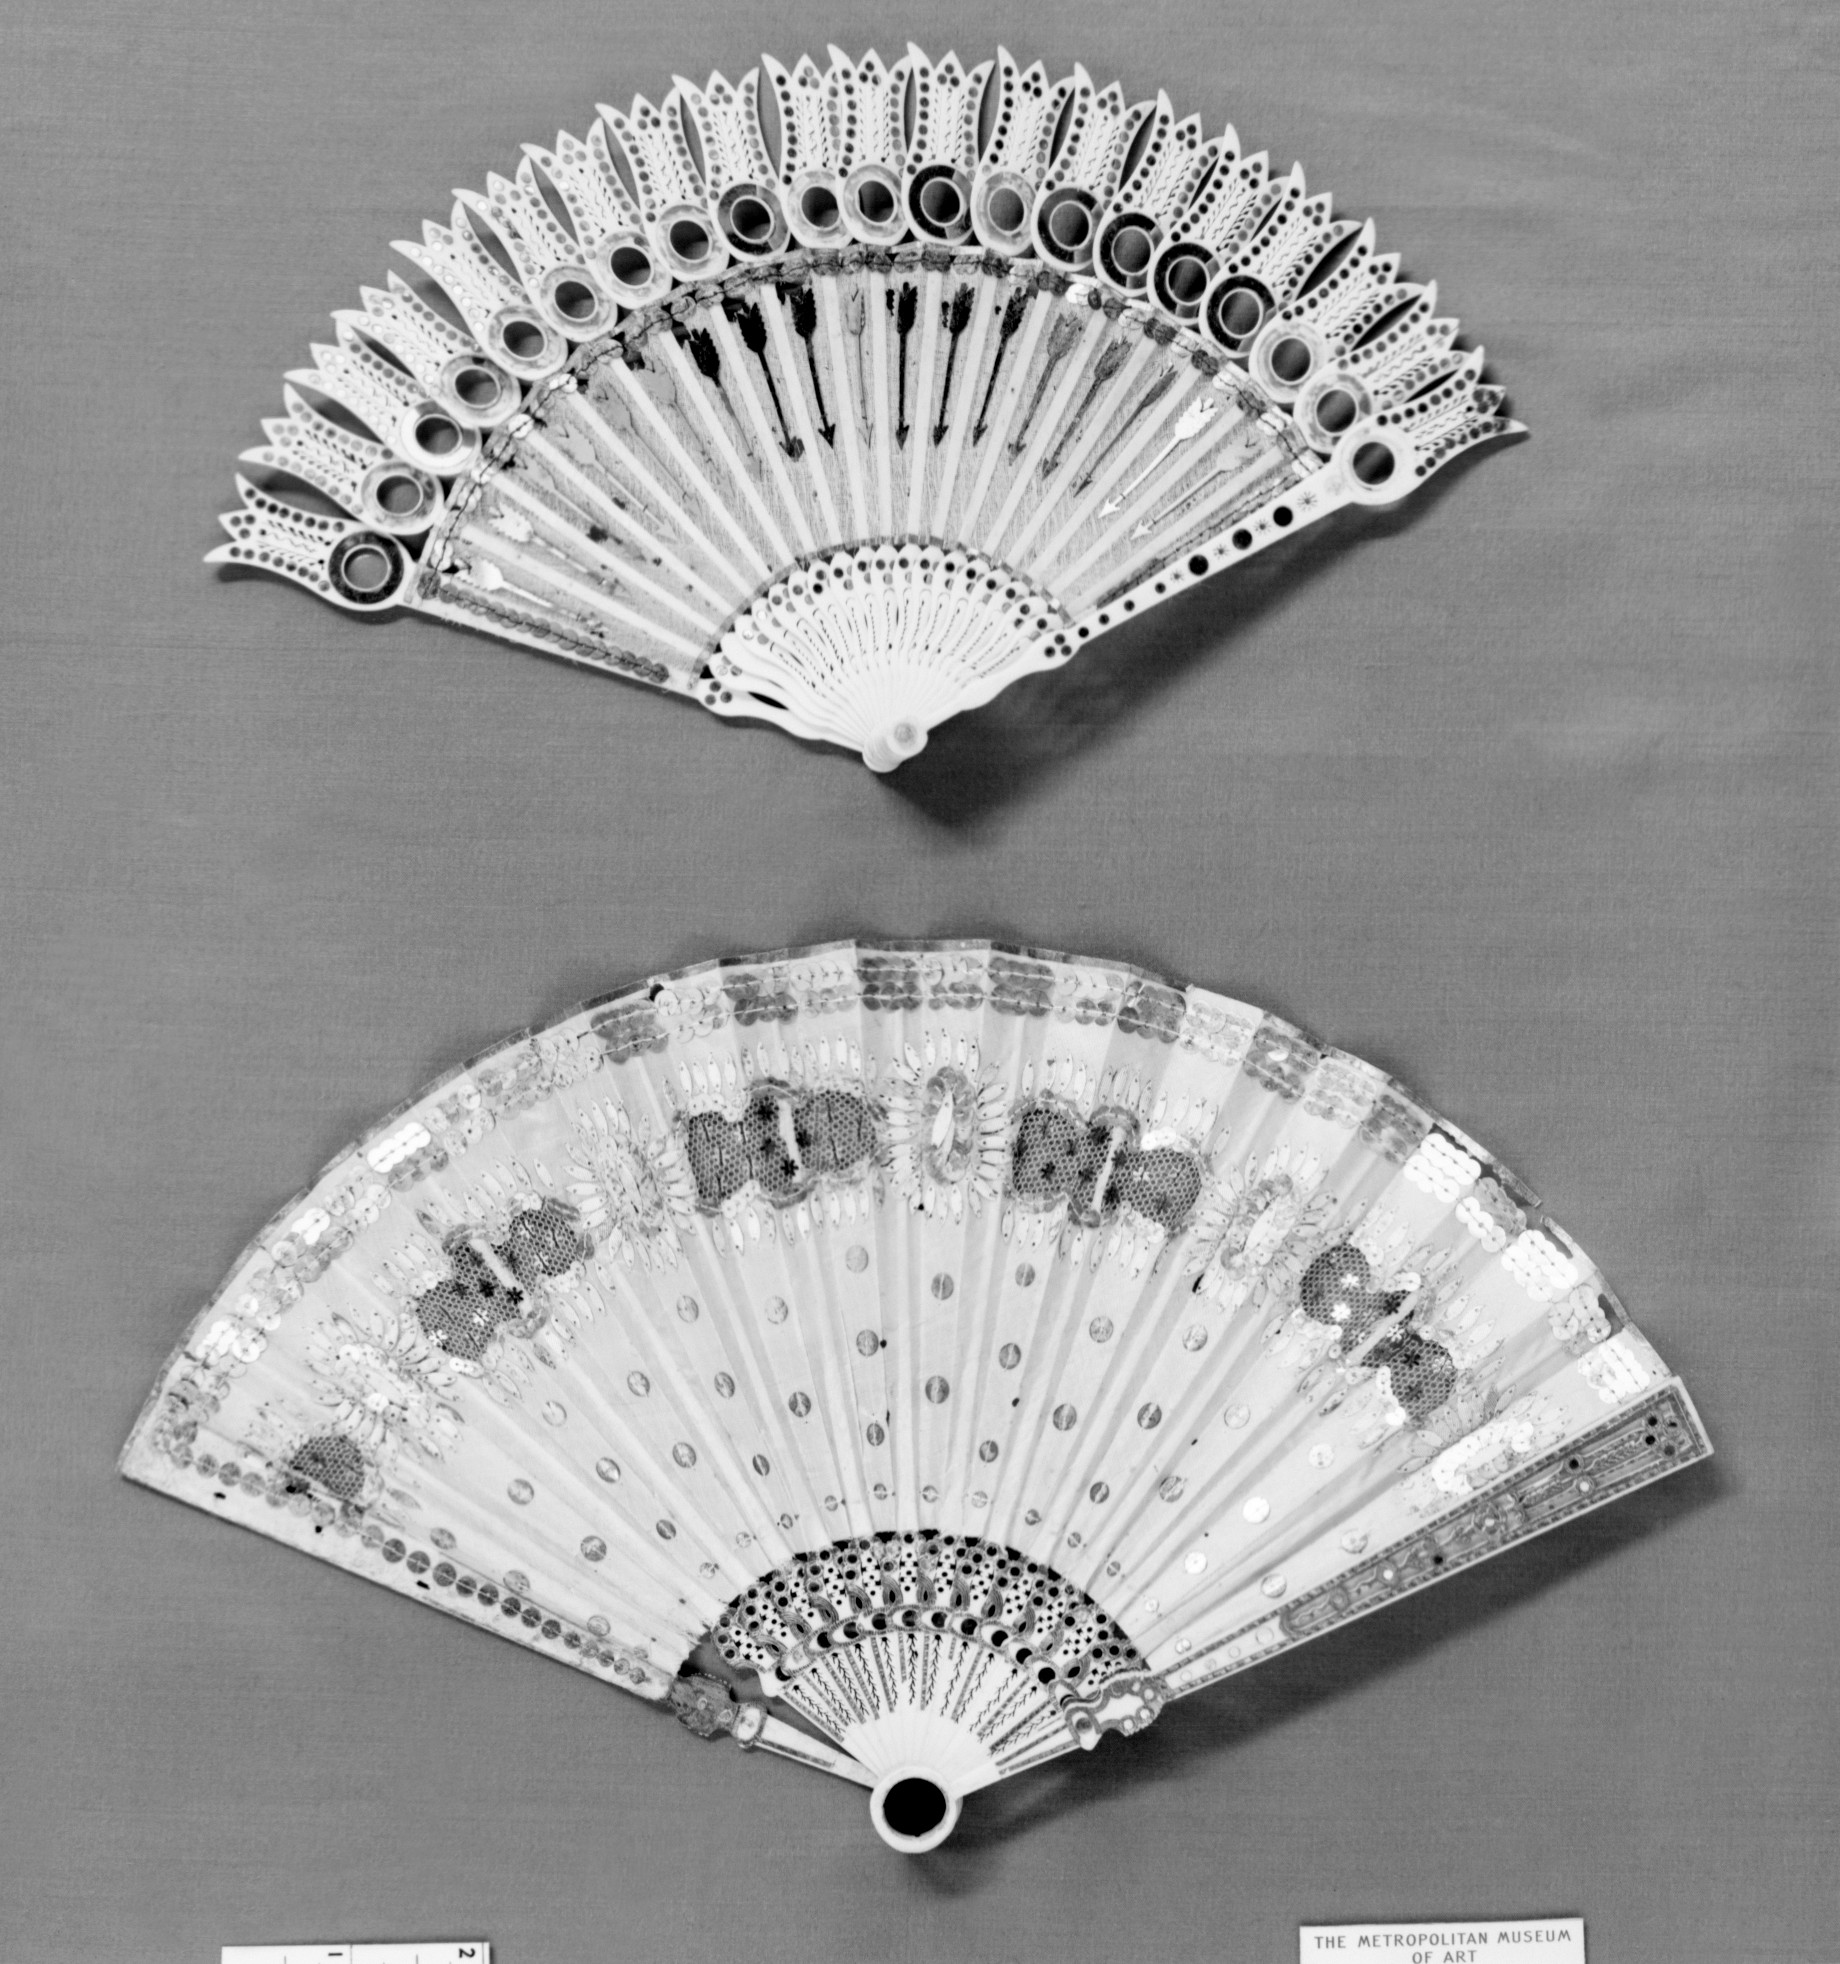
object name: fan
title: Lorgnette Fan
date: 1767-1833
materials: textile, ivory